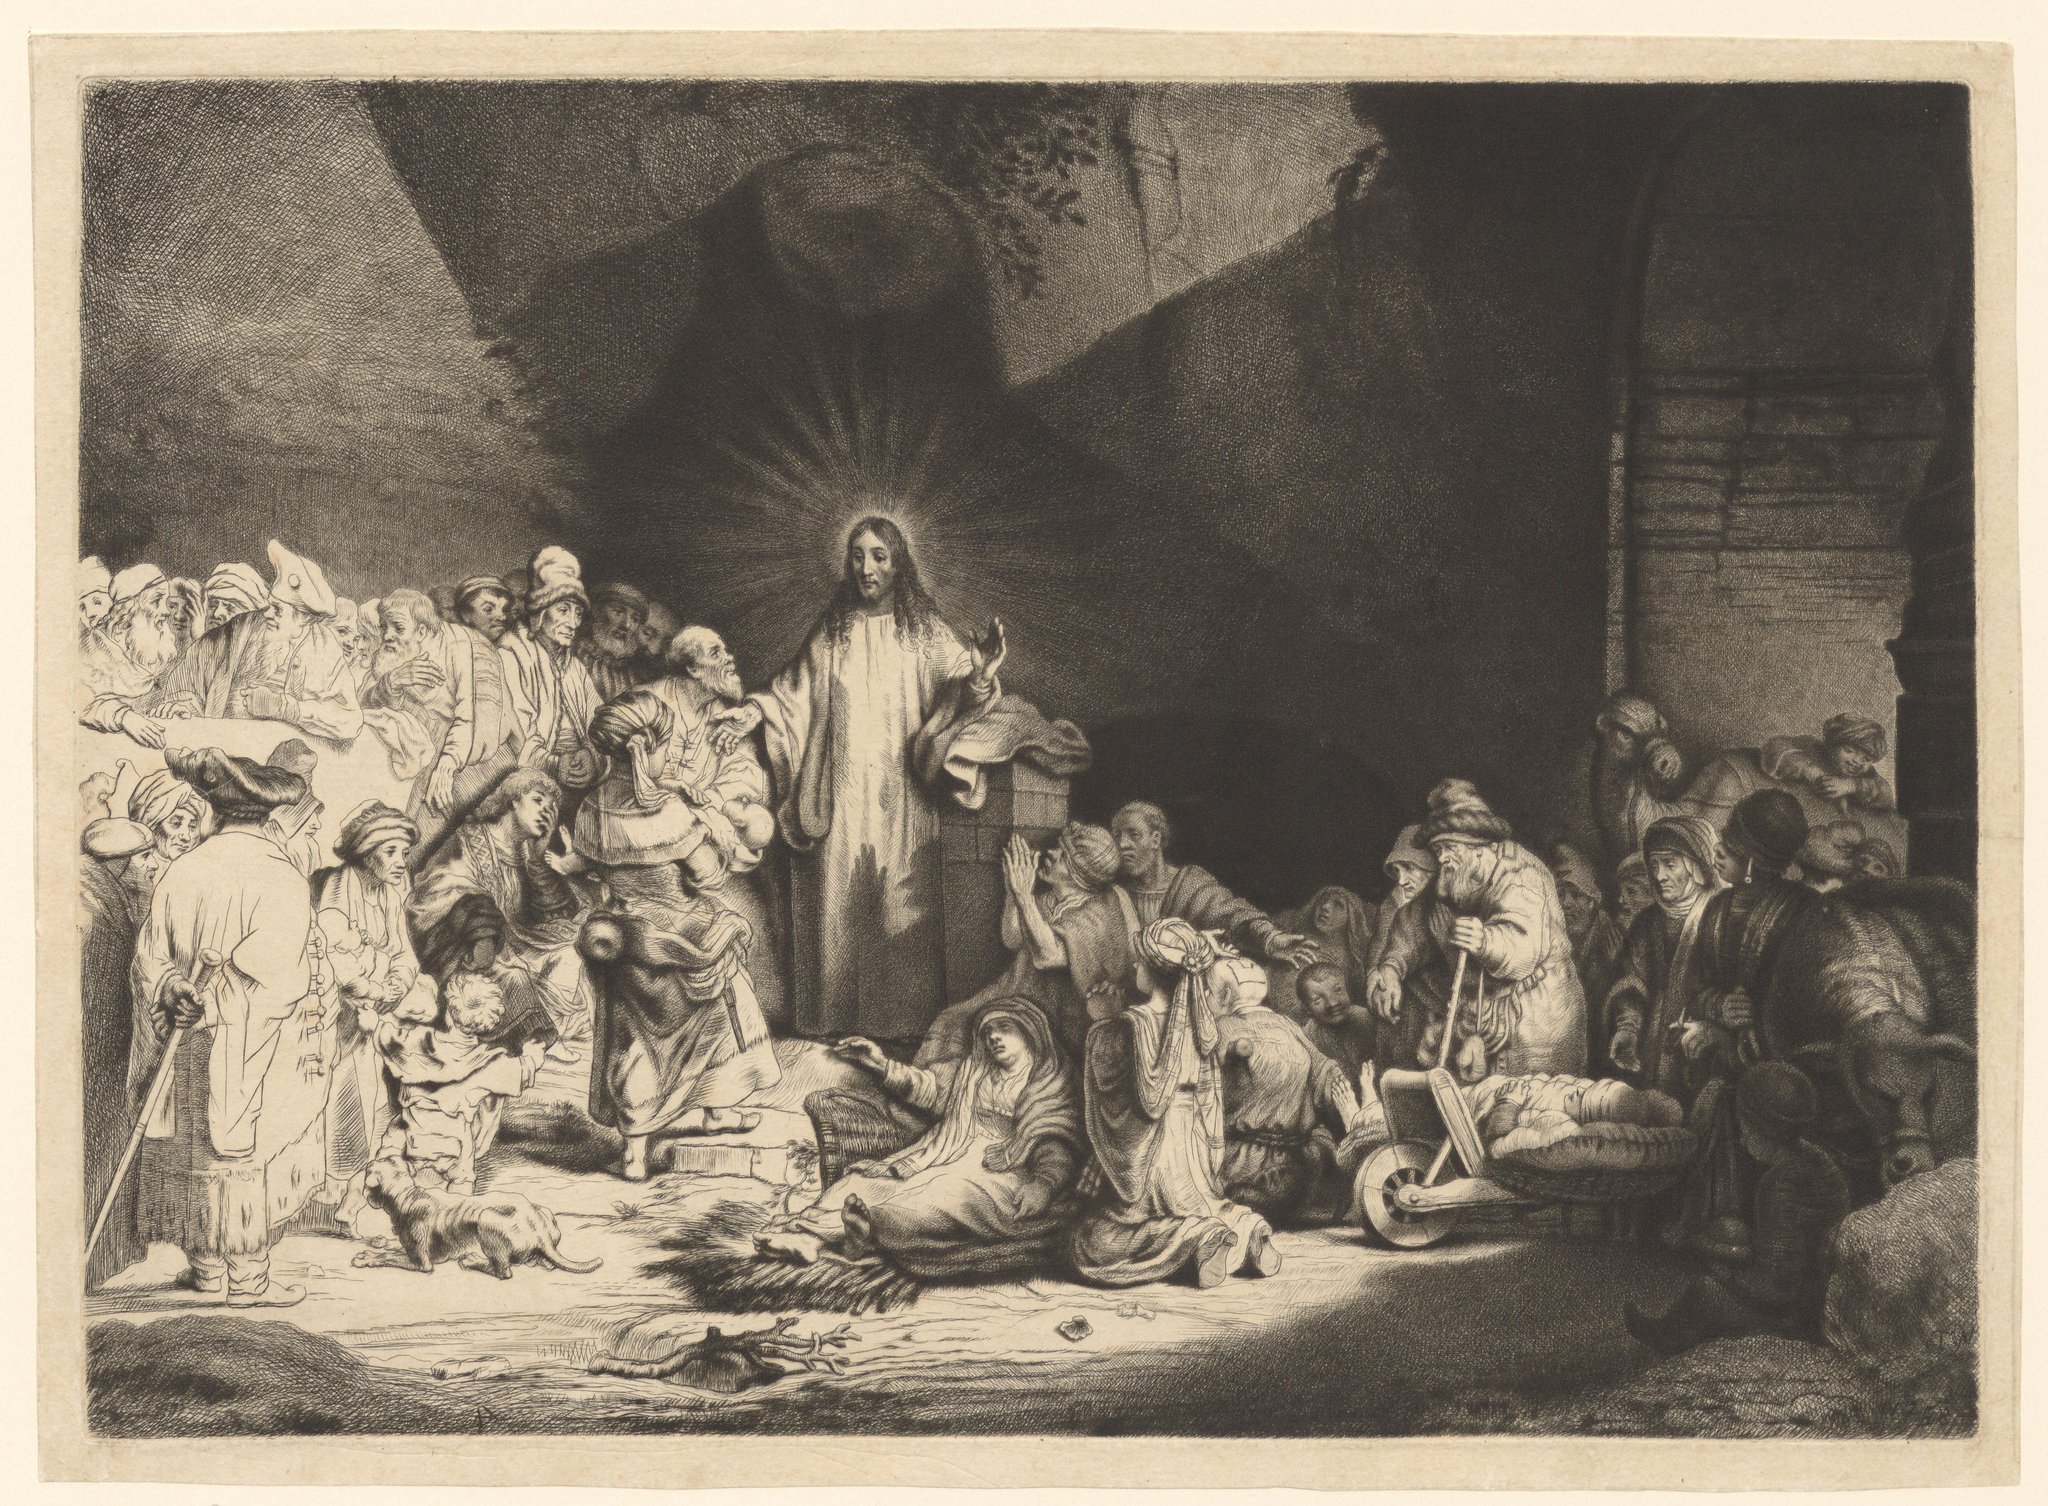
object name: print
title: Predikende Christus (De Honderdguldenprent)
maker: thomas worlidge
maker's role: print maker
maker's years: 1700-1766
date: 1758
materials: paper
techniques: drypoint, etching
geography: london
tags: christ preaching or teaching (in general)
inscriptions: collector's mark: Lugt 2228, collector's mark: Lugt 2760